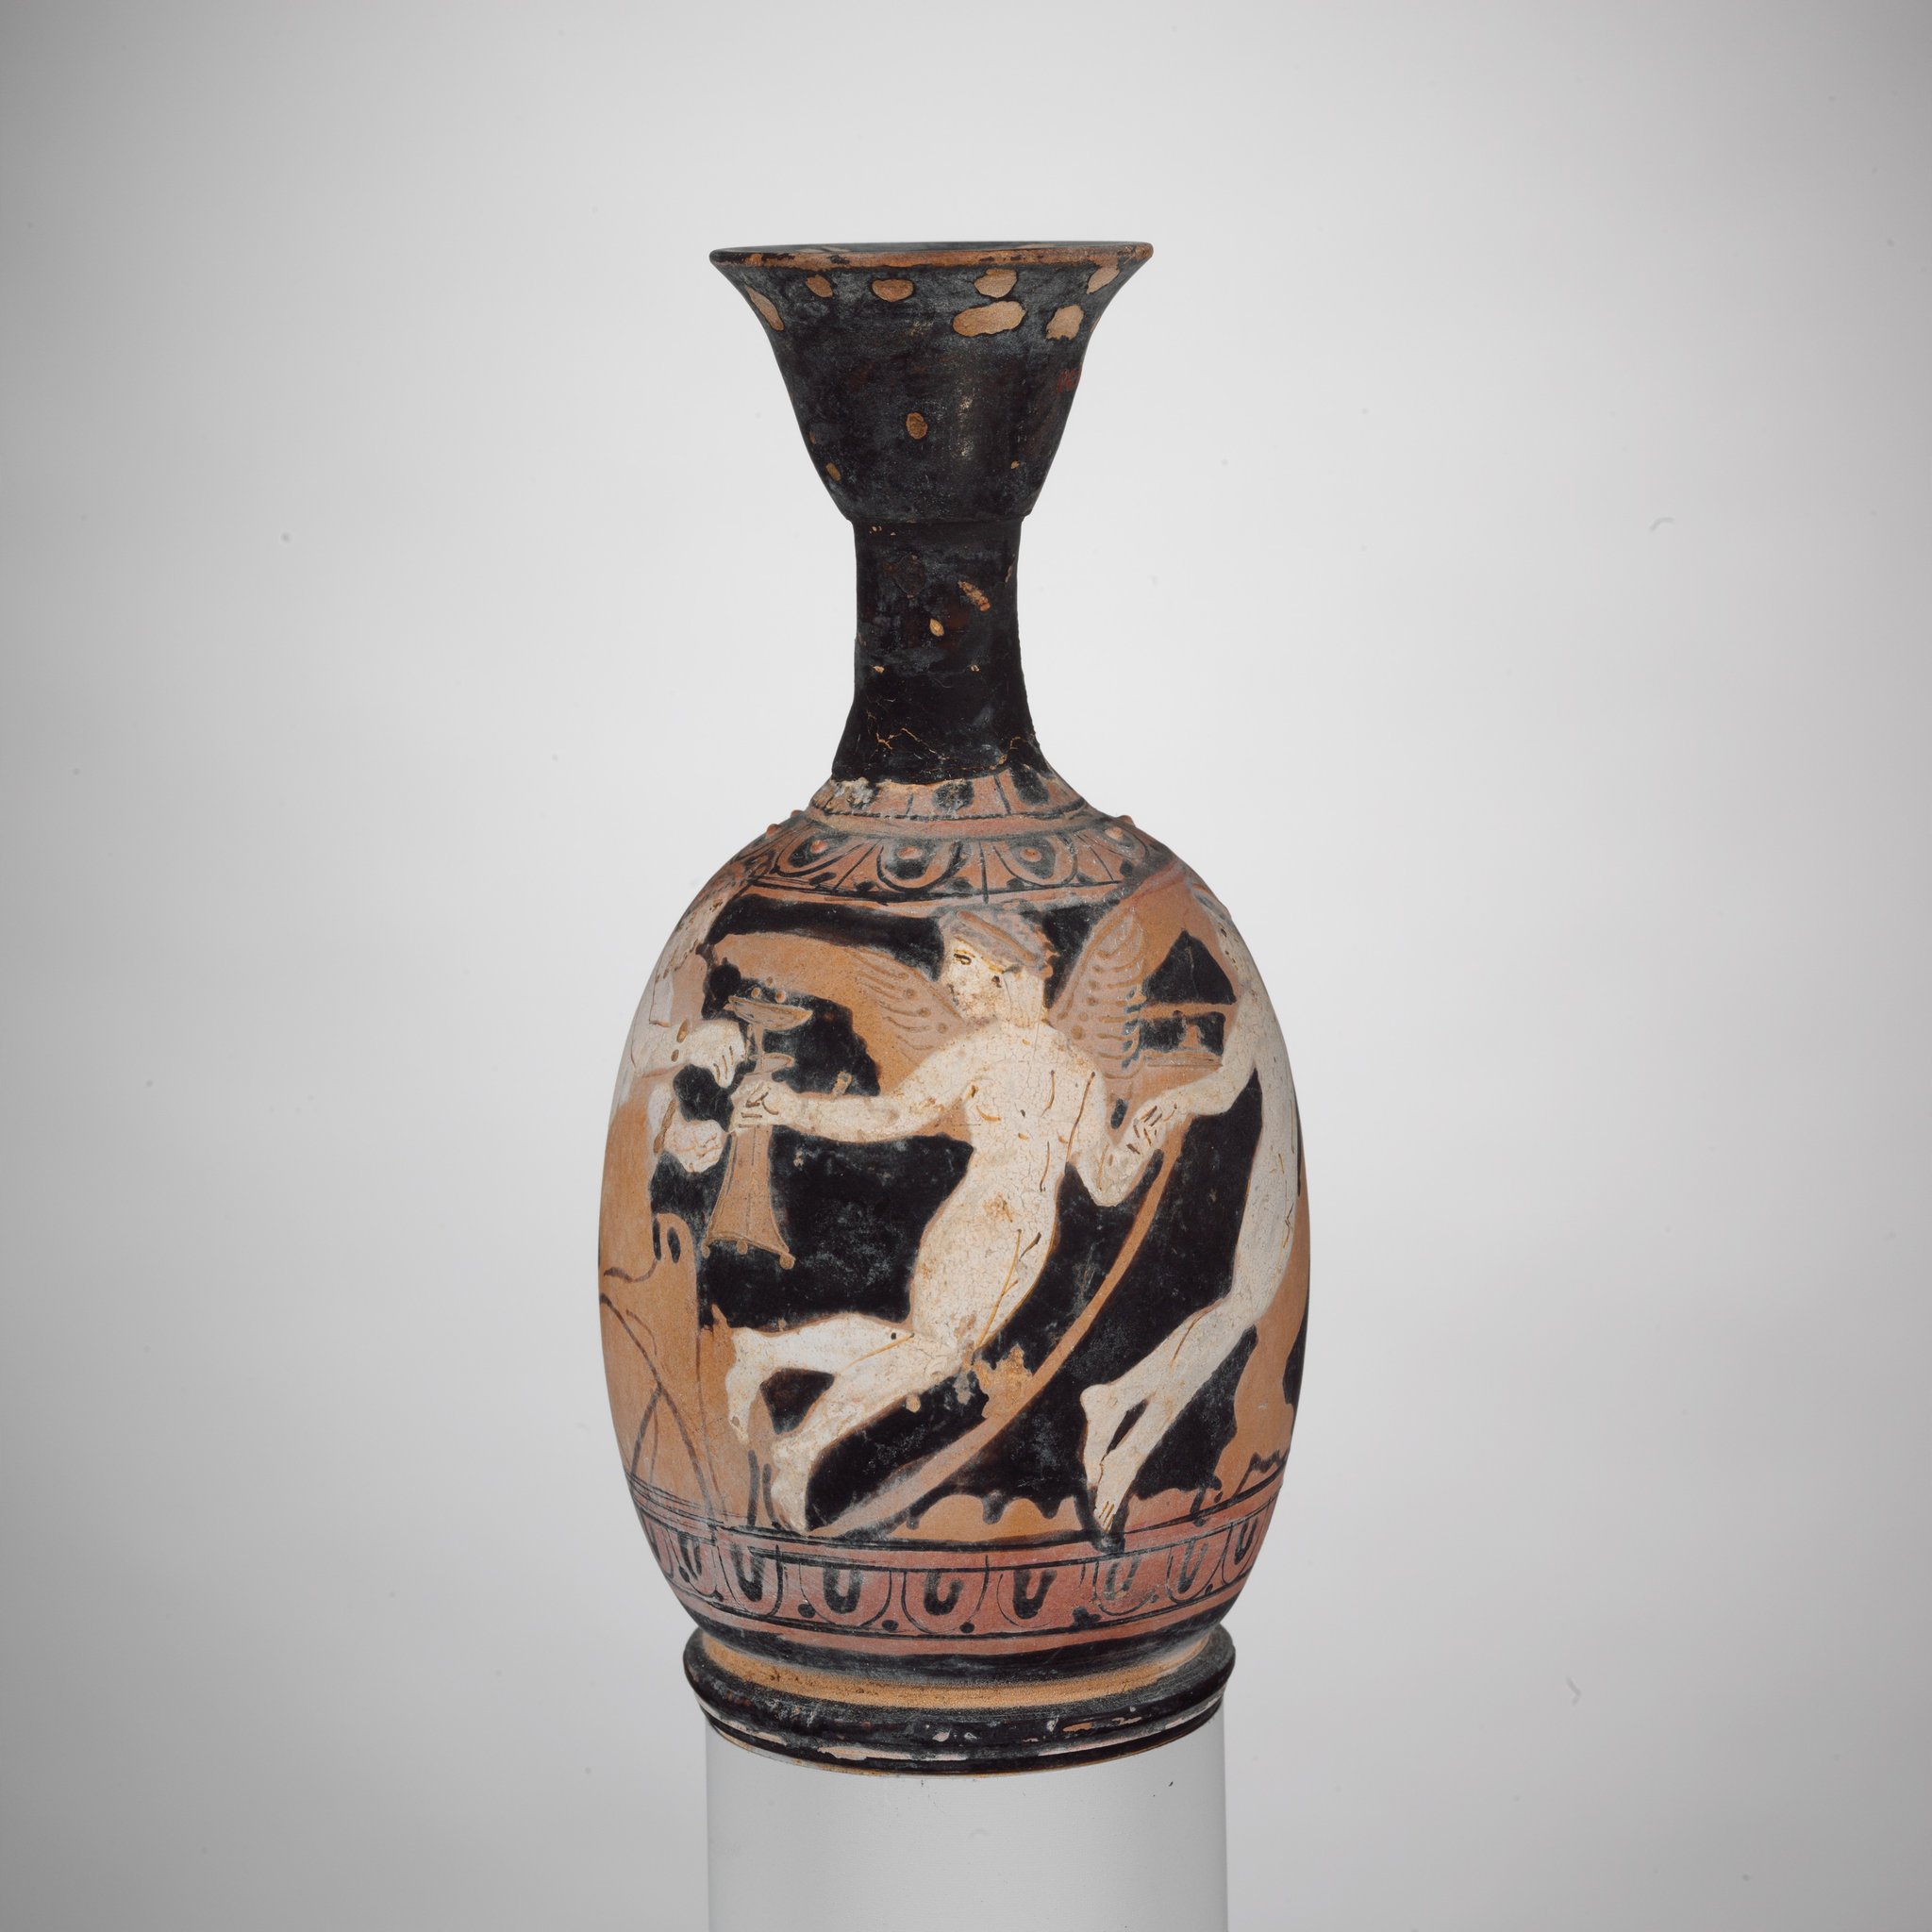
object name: squat lekythos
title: Terracotta squat lekythos (oil jar)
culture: greek, attic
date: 400-368 BCE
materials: terracotta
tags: aphrodite,eros